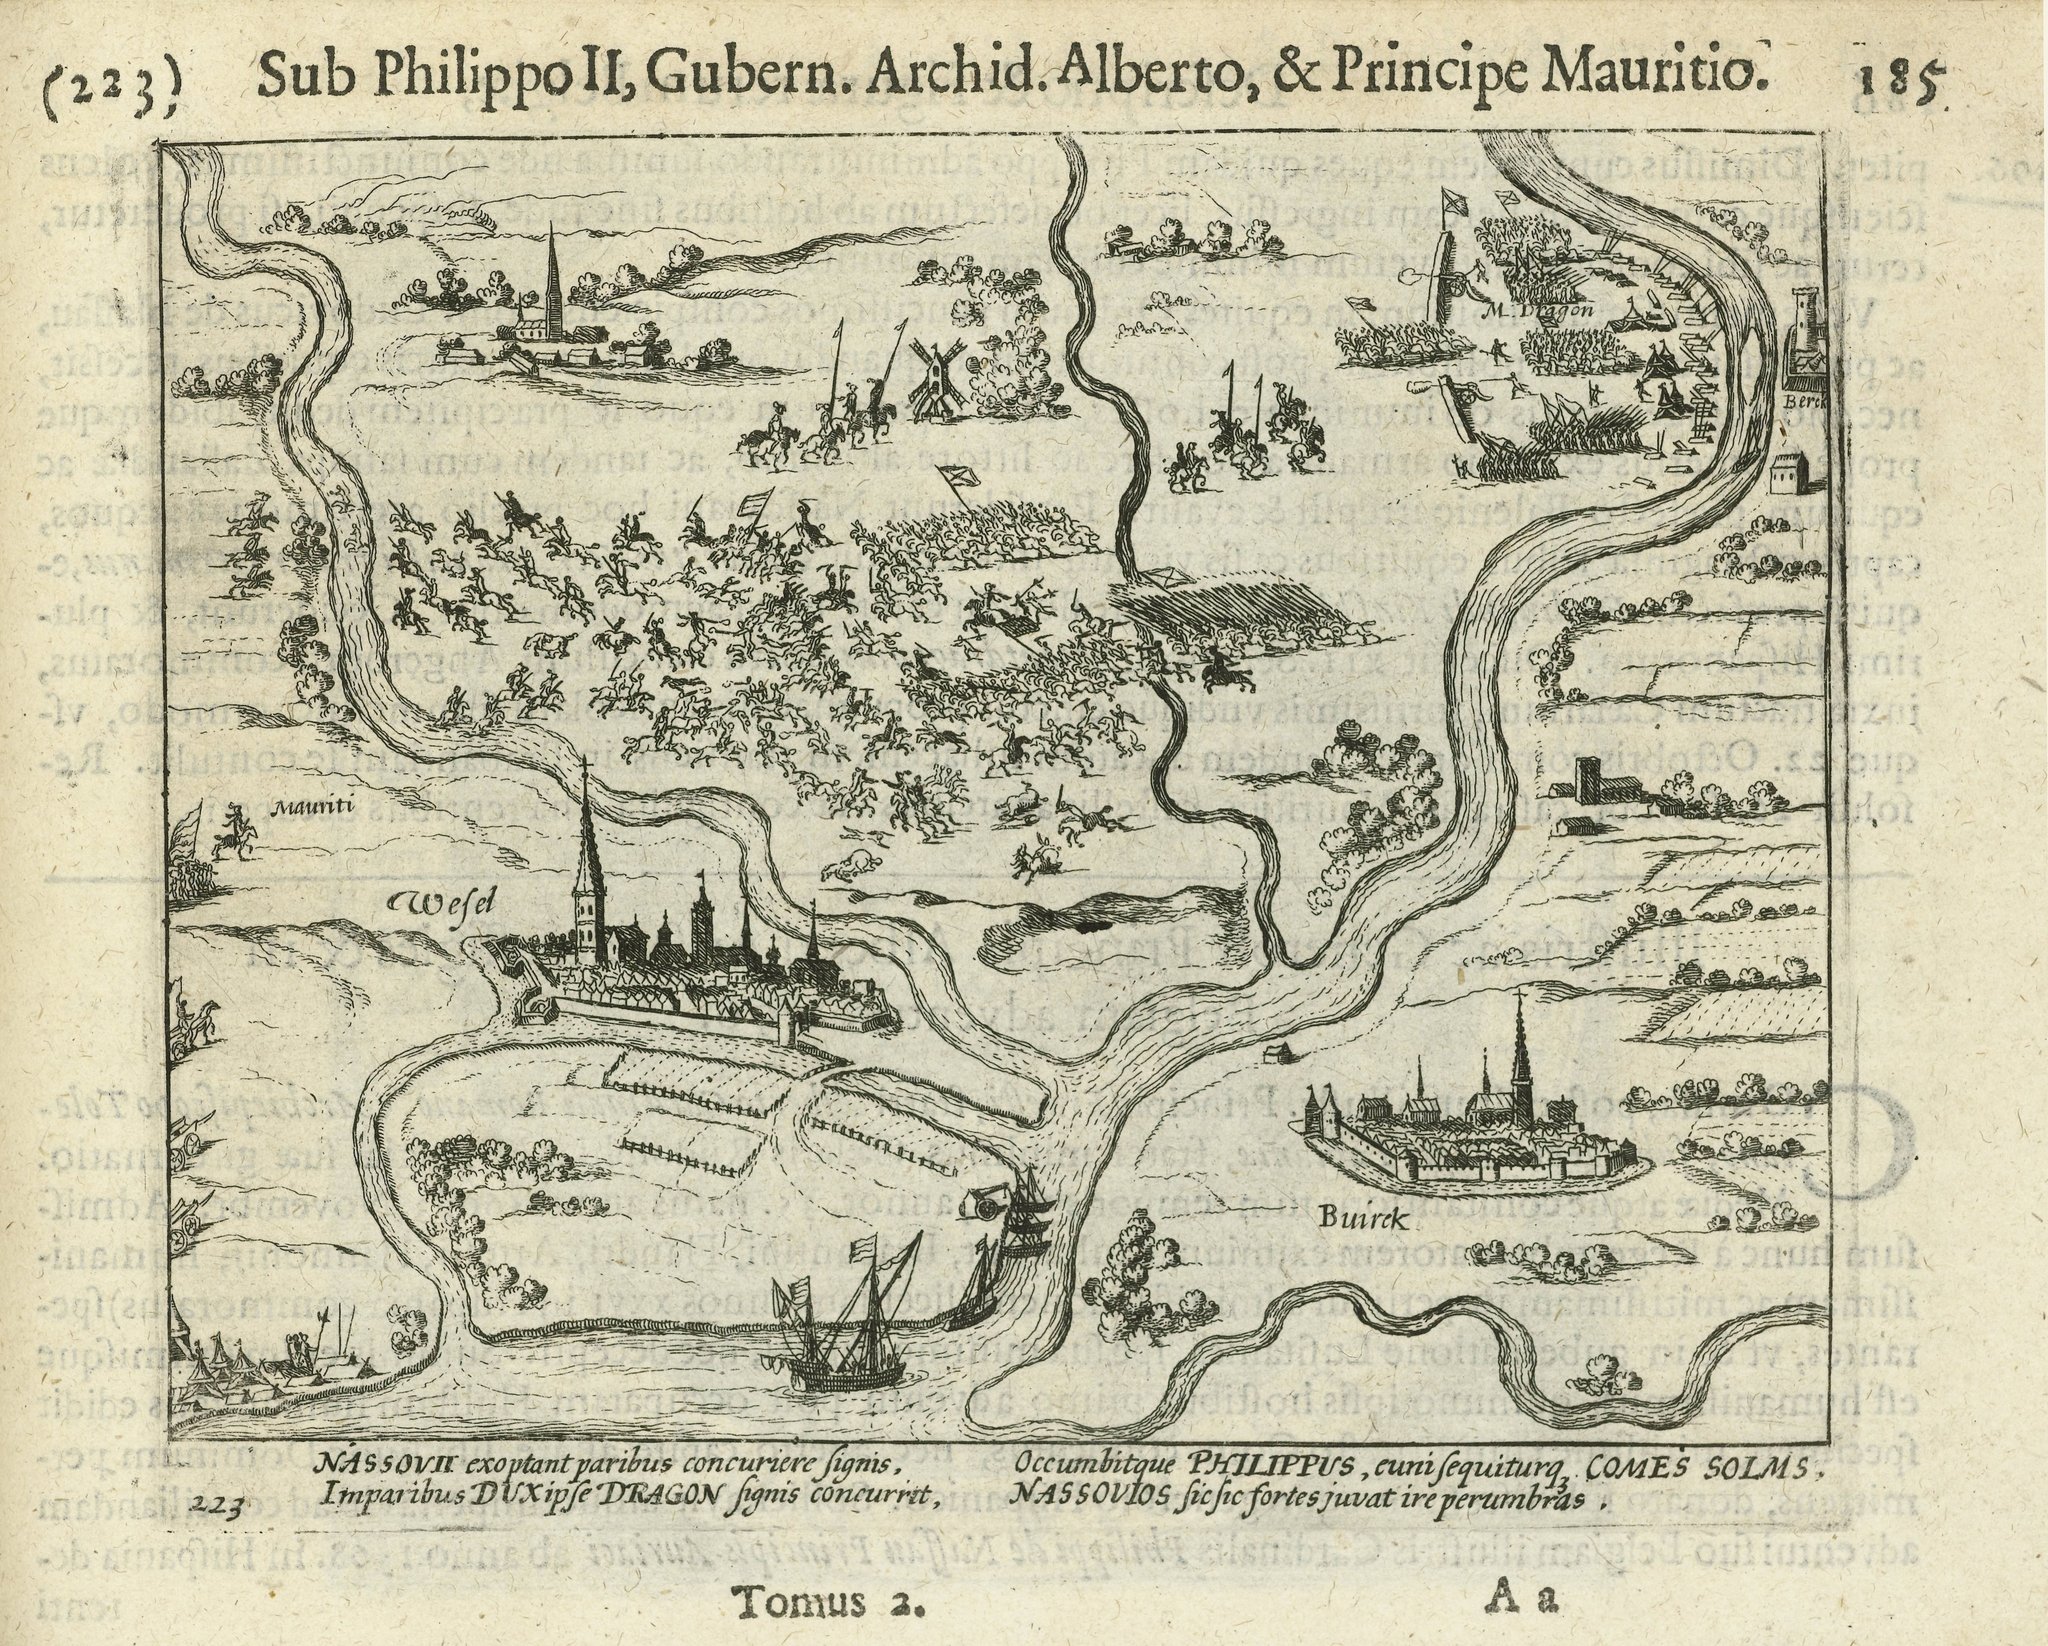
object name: print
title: Nederlaag van het Staatse leger bij Wesel, 1595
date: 1613-1615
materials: paper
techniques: etching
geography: amsterdam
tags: antwerp, raising the siege with outside assistance, relief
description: Nederlaag van het Staatse leger bij Wesel. Ruiters van Maurits worden verslagen door de ruiters van Mondragon bij Wesel, 2 september 1595. Graaf van Solms en Filips van Nassau komen om het leven en graaf Ernst van Nassau wordt gevangen genomen. Onderaan Wesel, boven Rijnberg. Met onderschrift van 4 regels in het Latijn. Genummerd: 223. Bedrukt op achterzijde met tekst in het Latijn.